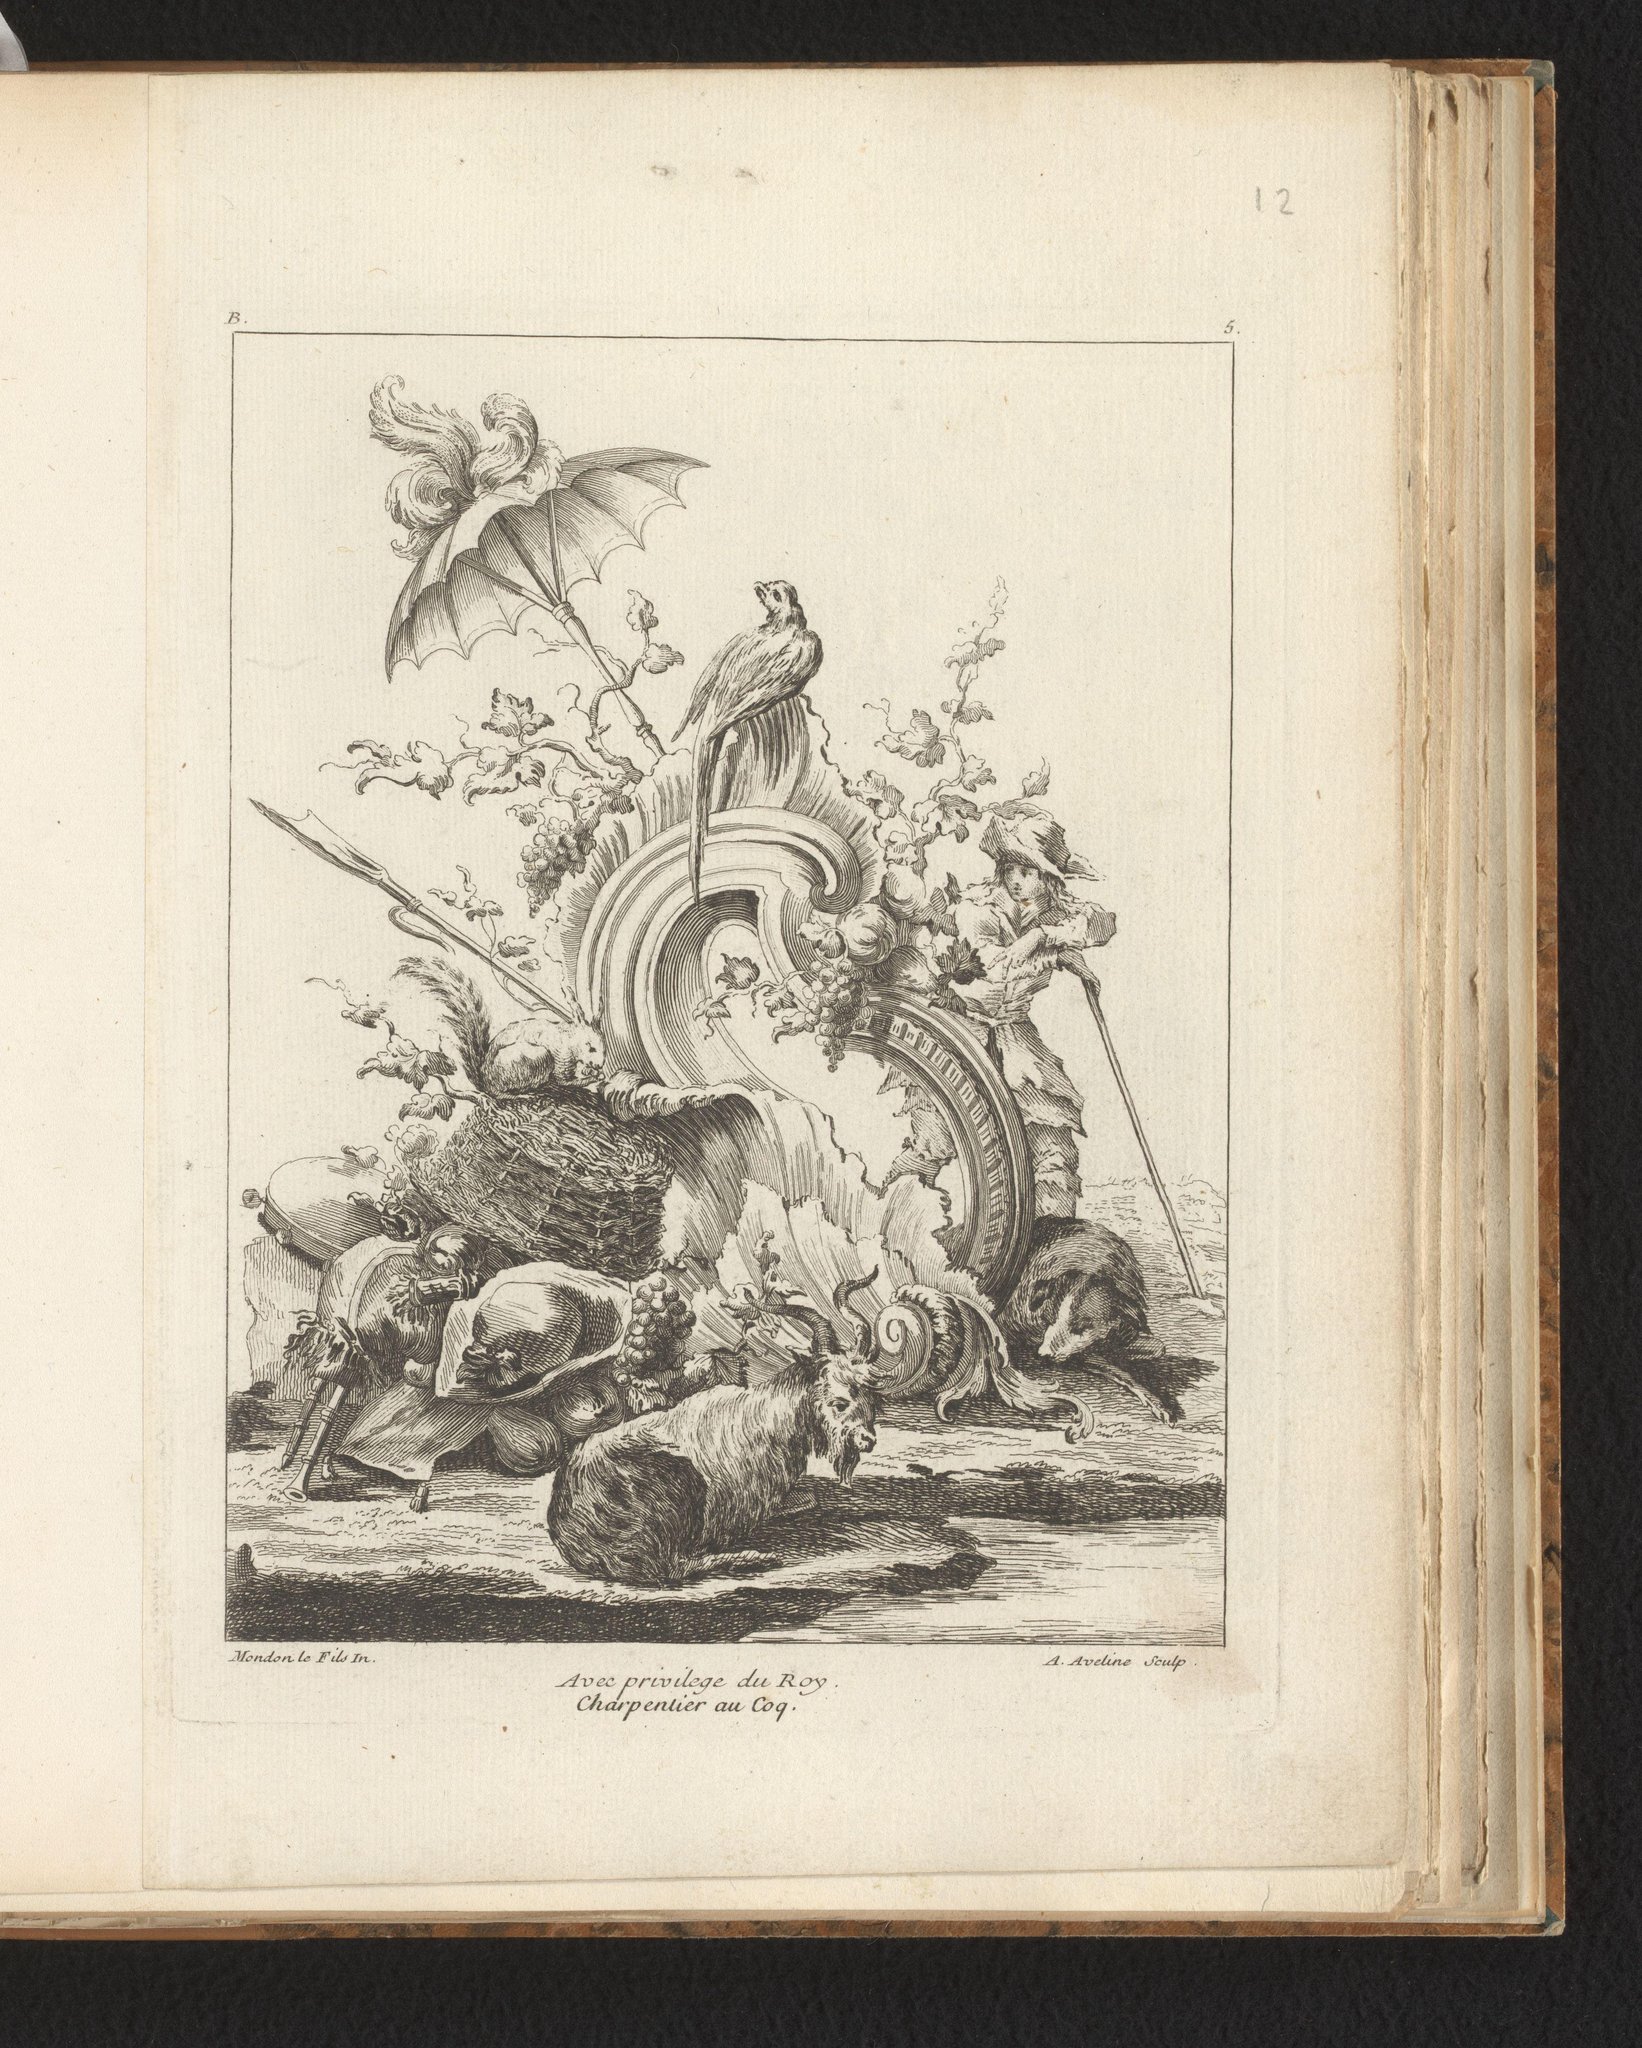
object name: print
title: Rocaille met dieren en doedelzak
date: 1736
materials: paper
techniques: etching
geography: france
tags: rocaille ornament, bagpipe, musette, herd, flock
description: Deze serie is linksboven genummerd met een letter B. Prent maakt deel uit van een album.